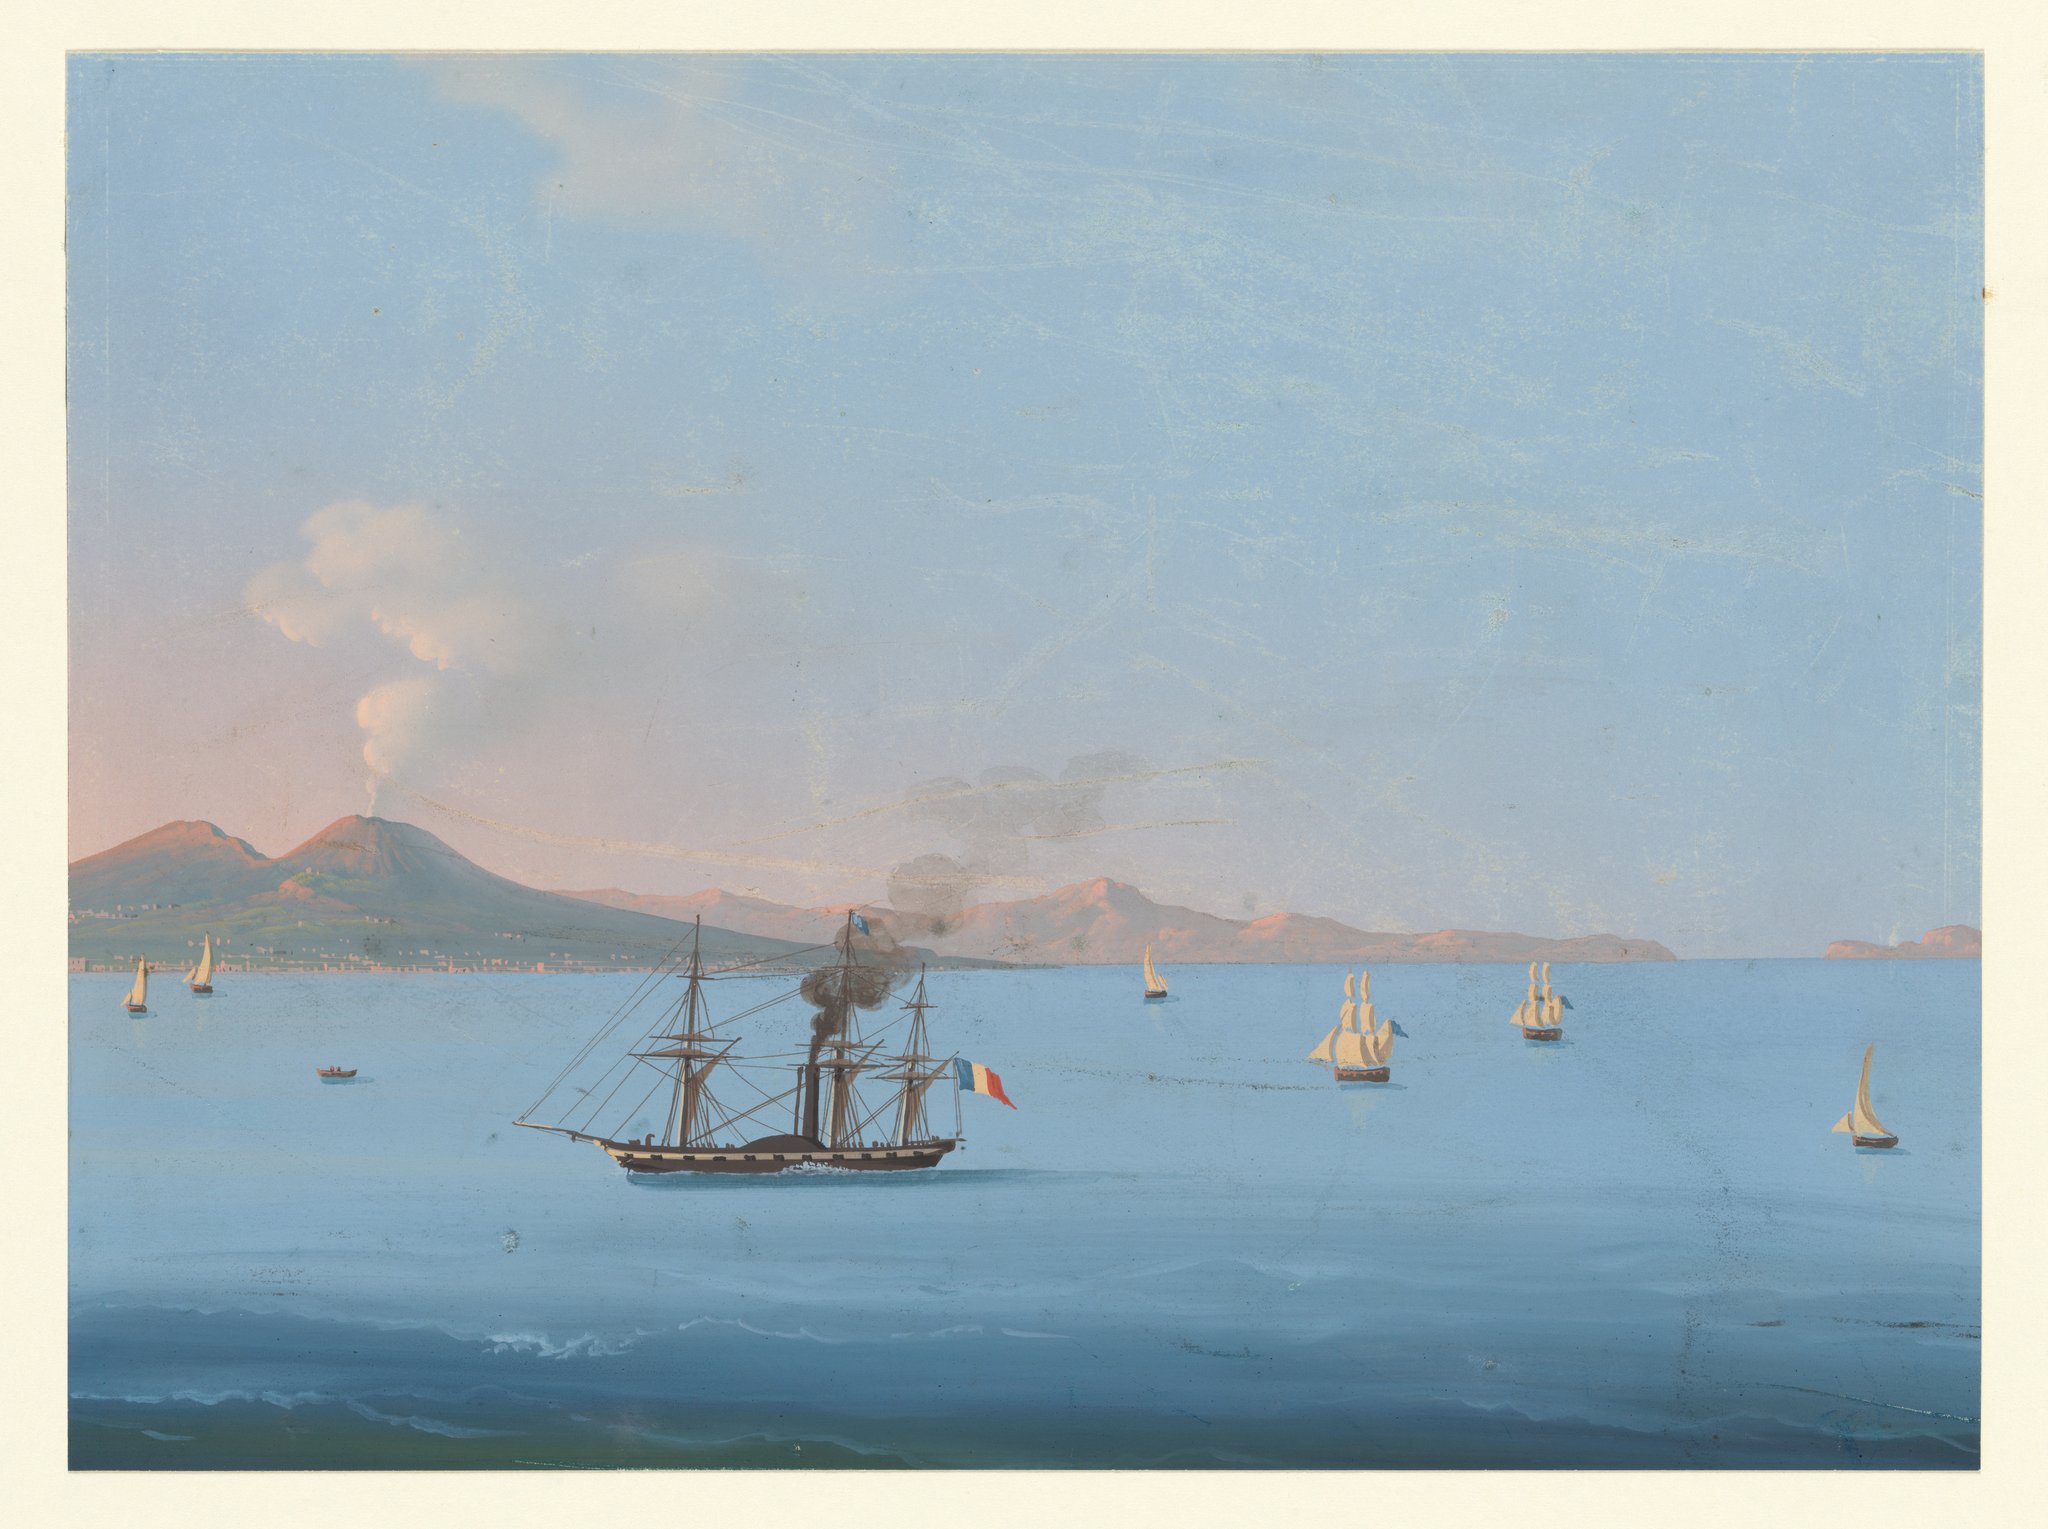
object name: drawing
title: The Bay of Naples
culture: italian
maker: Anonymous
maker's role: artist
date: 1835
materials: gouache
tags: ships